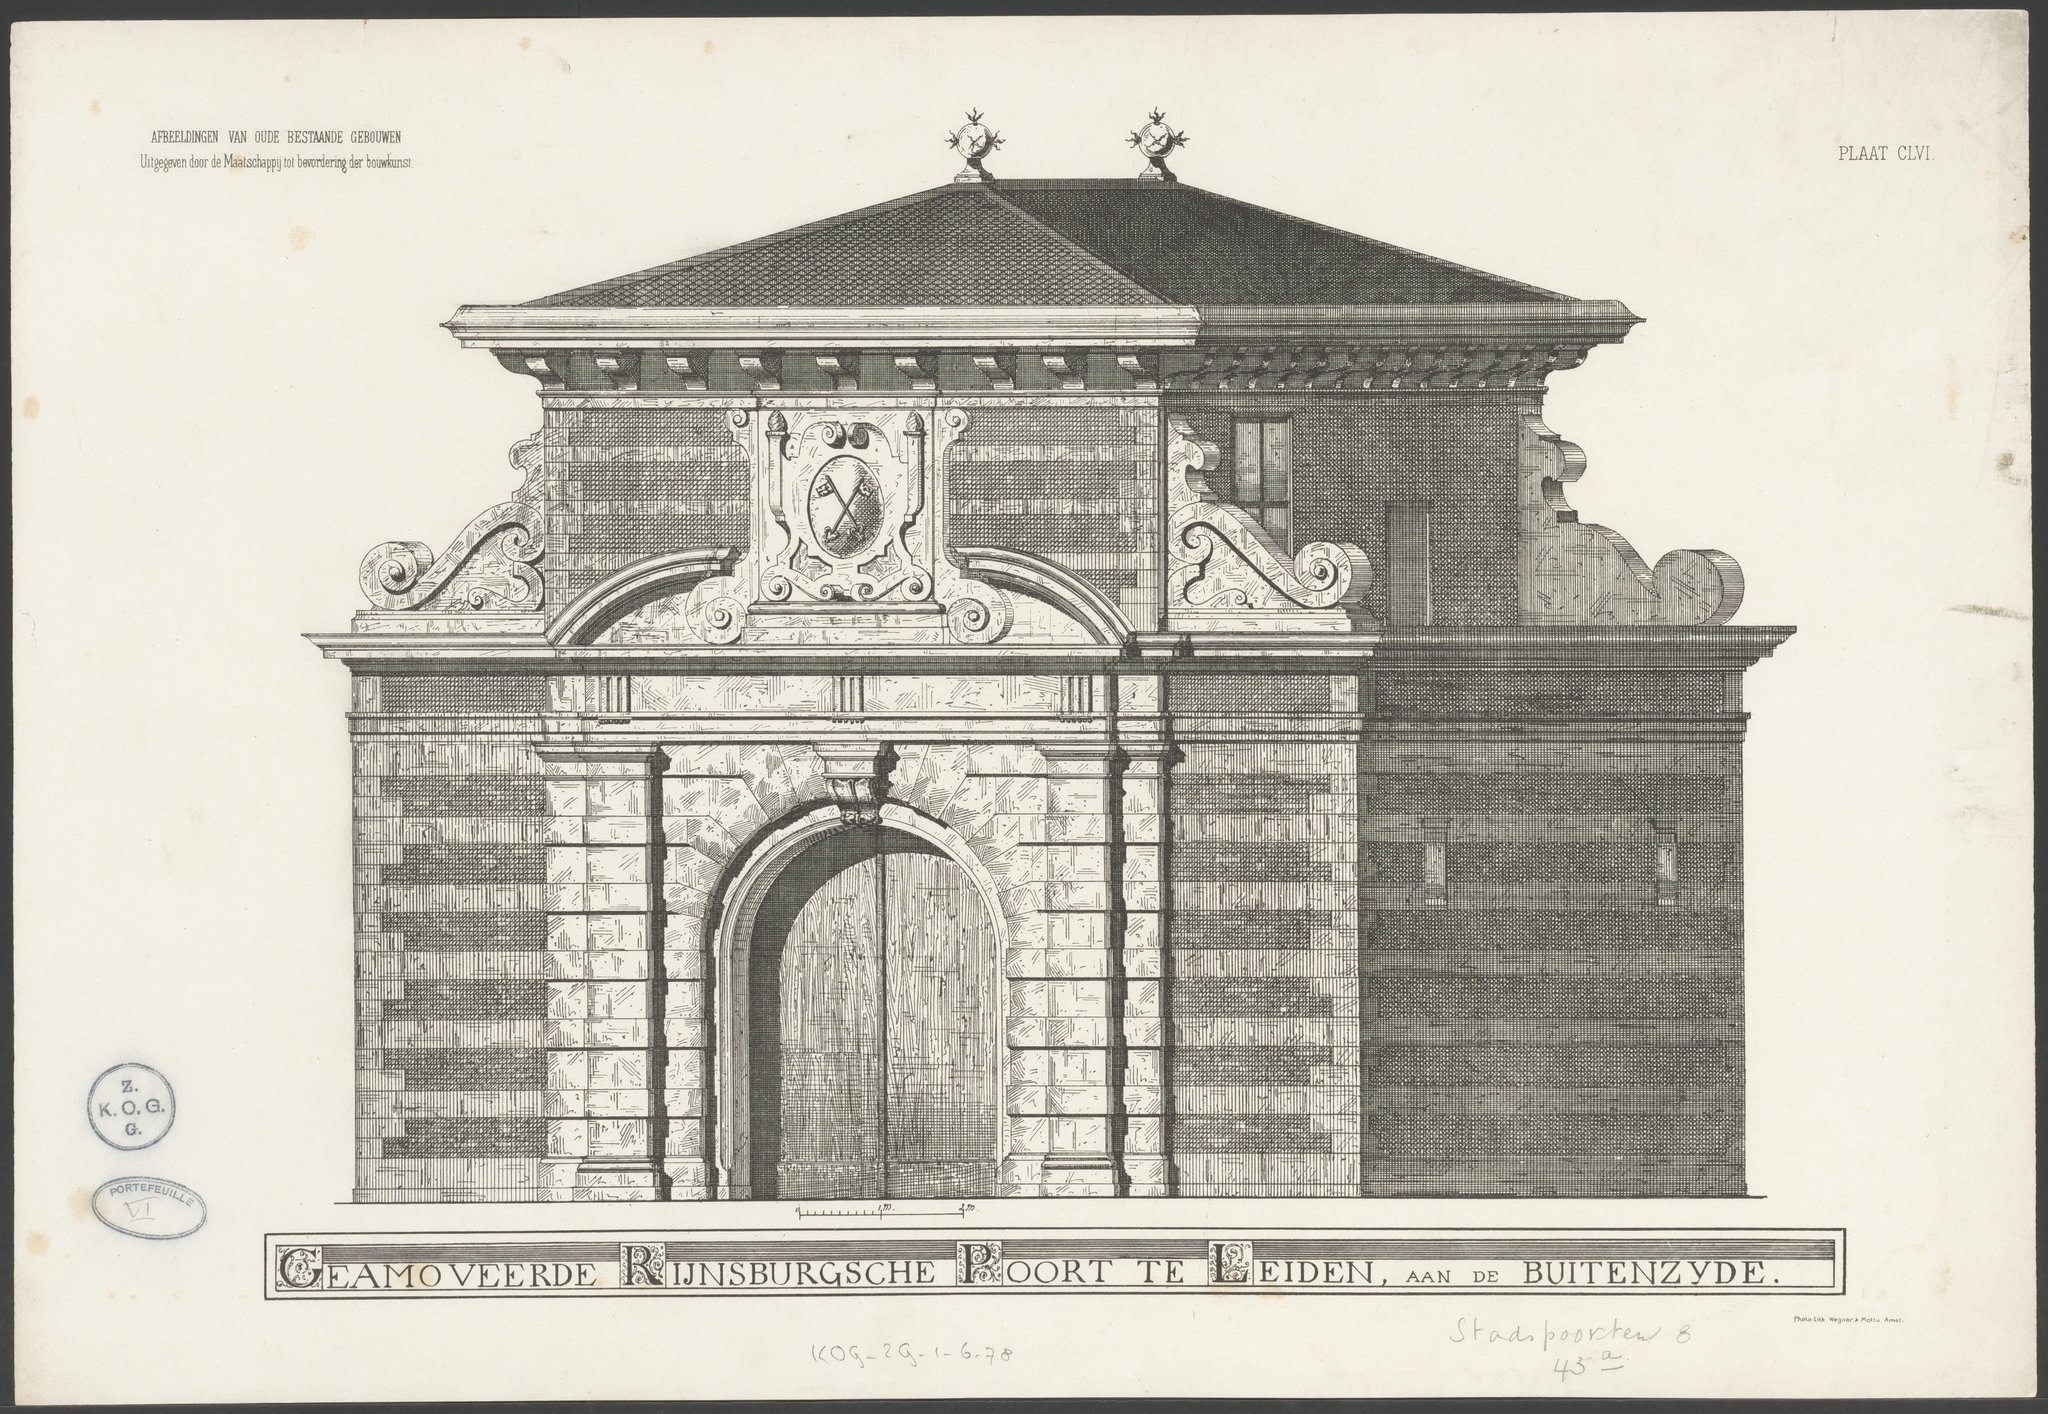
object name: photomechanical print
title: Afbeeldingen van oude bestaande gebouwen, uitgegeven door de Maatschappij tot bevordering der bouwkunst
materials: paper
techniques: photolithography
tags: city-gate, leiden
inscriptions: collector's mark: Lugt 1641, stamp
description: Rechtsboven genummerd: Plaat CLVI. Onderwerpsrubrieken binnen de Atlas Zeden en Gewoonten: Krijgswezen, Stadspoorten.